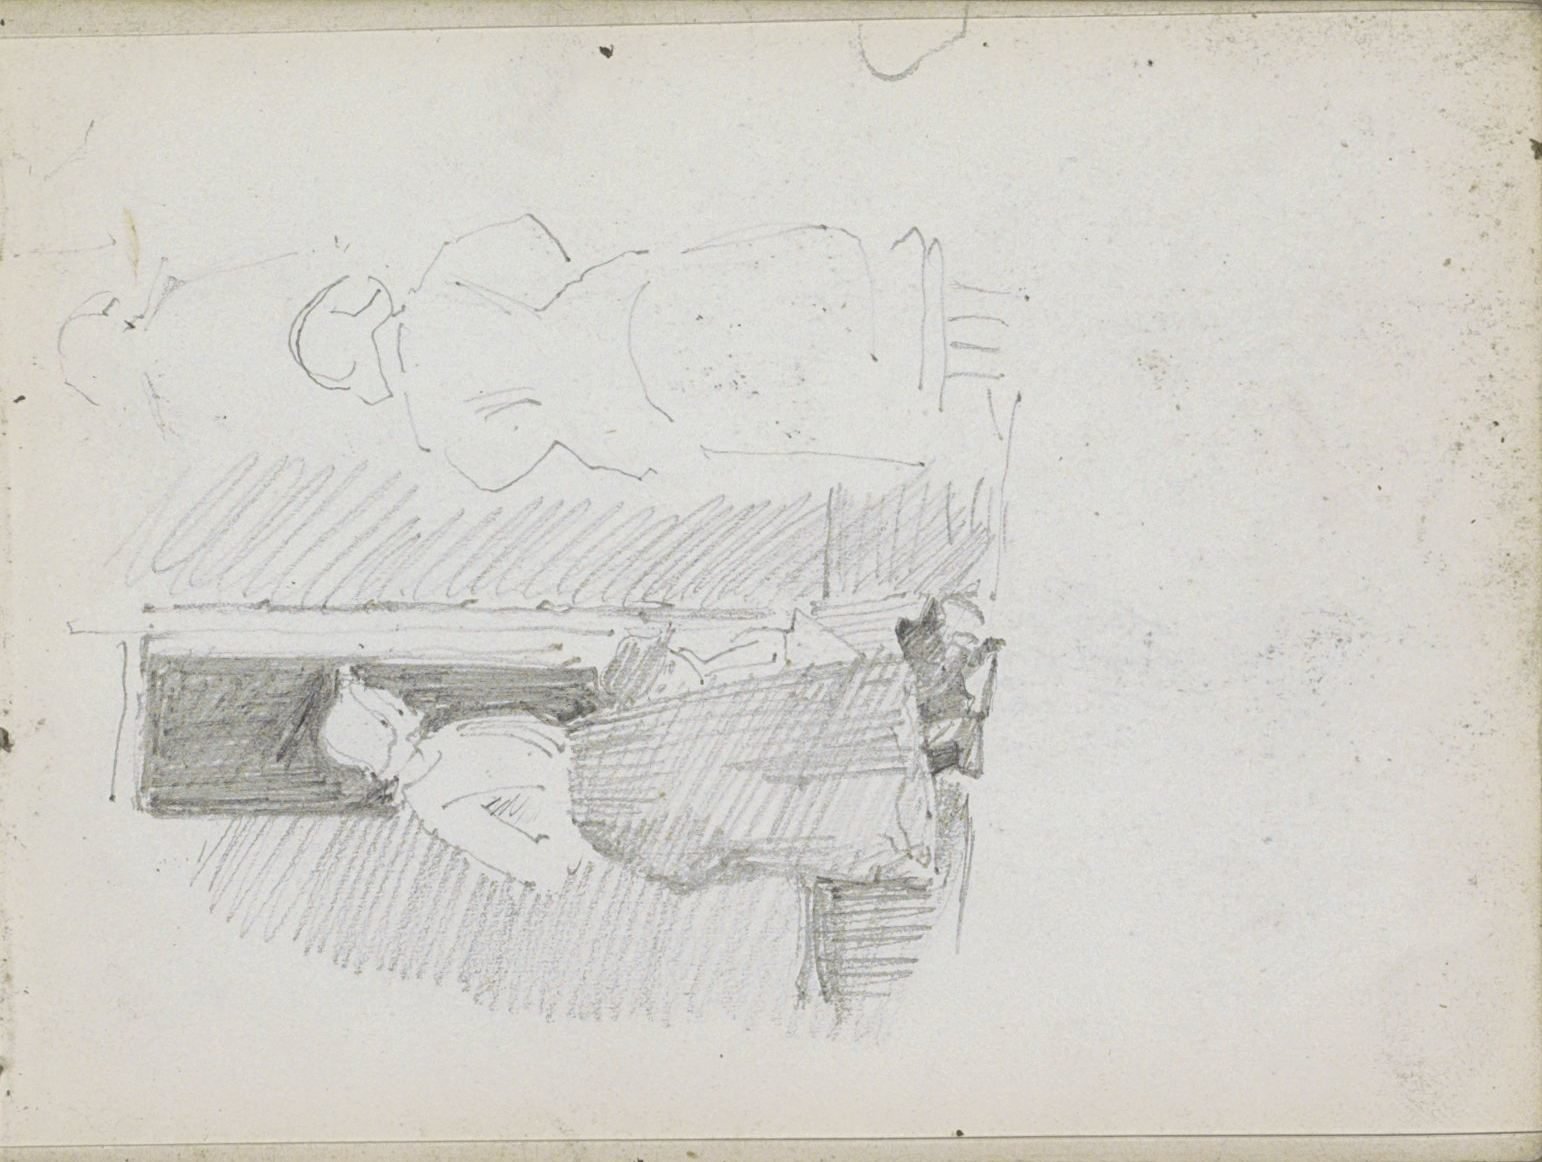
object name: sketchbook leaf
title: Twee vrouwen in klederdracht bij een deuropening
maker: george clausen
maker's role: draughtsman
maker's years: 1852-1912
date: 1874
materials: paper, pencil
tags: adult woman, open door, folk costume, regional costume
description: Blad 5 recto uit een schetsboek met 37 bladen.